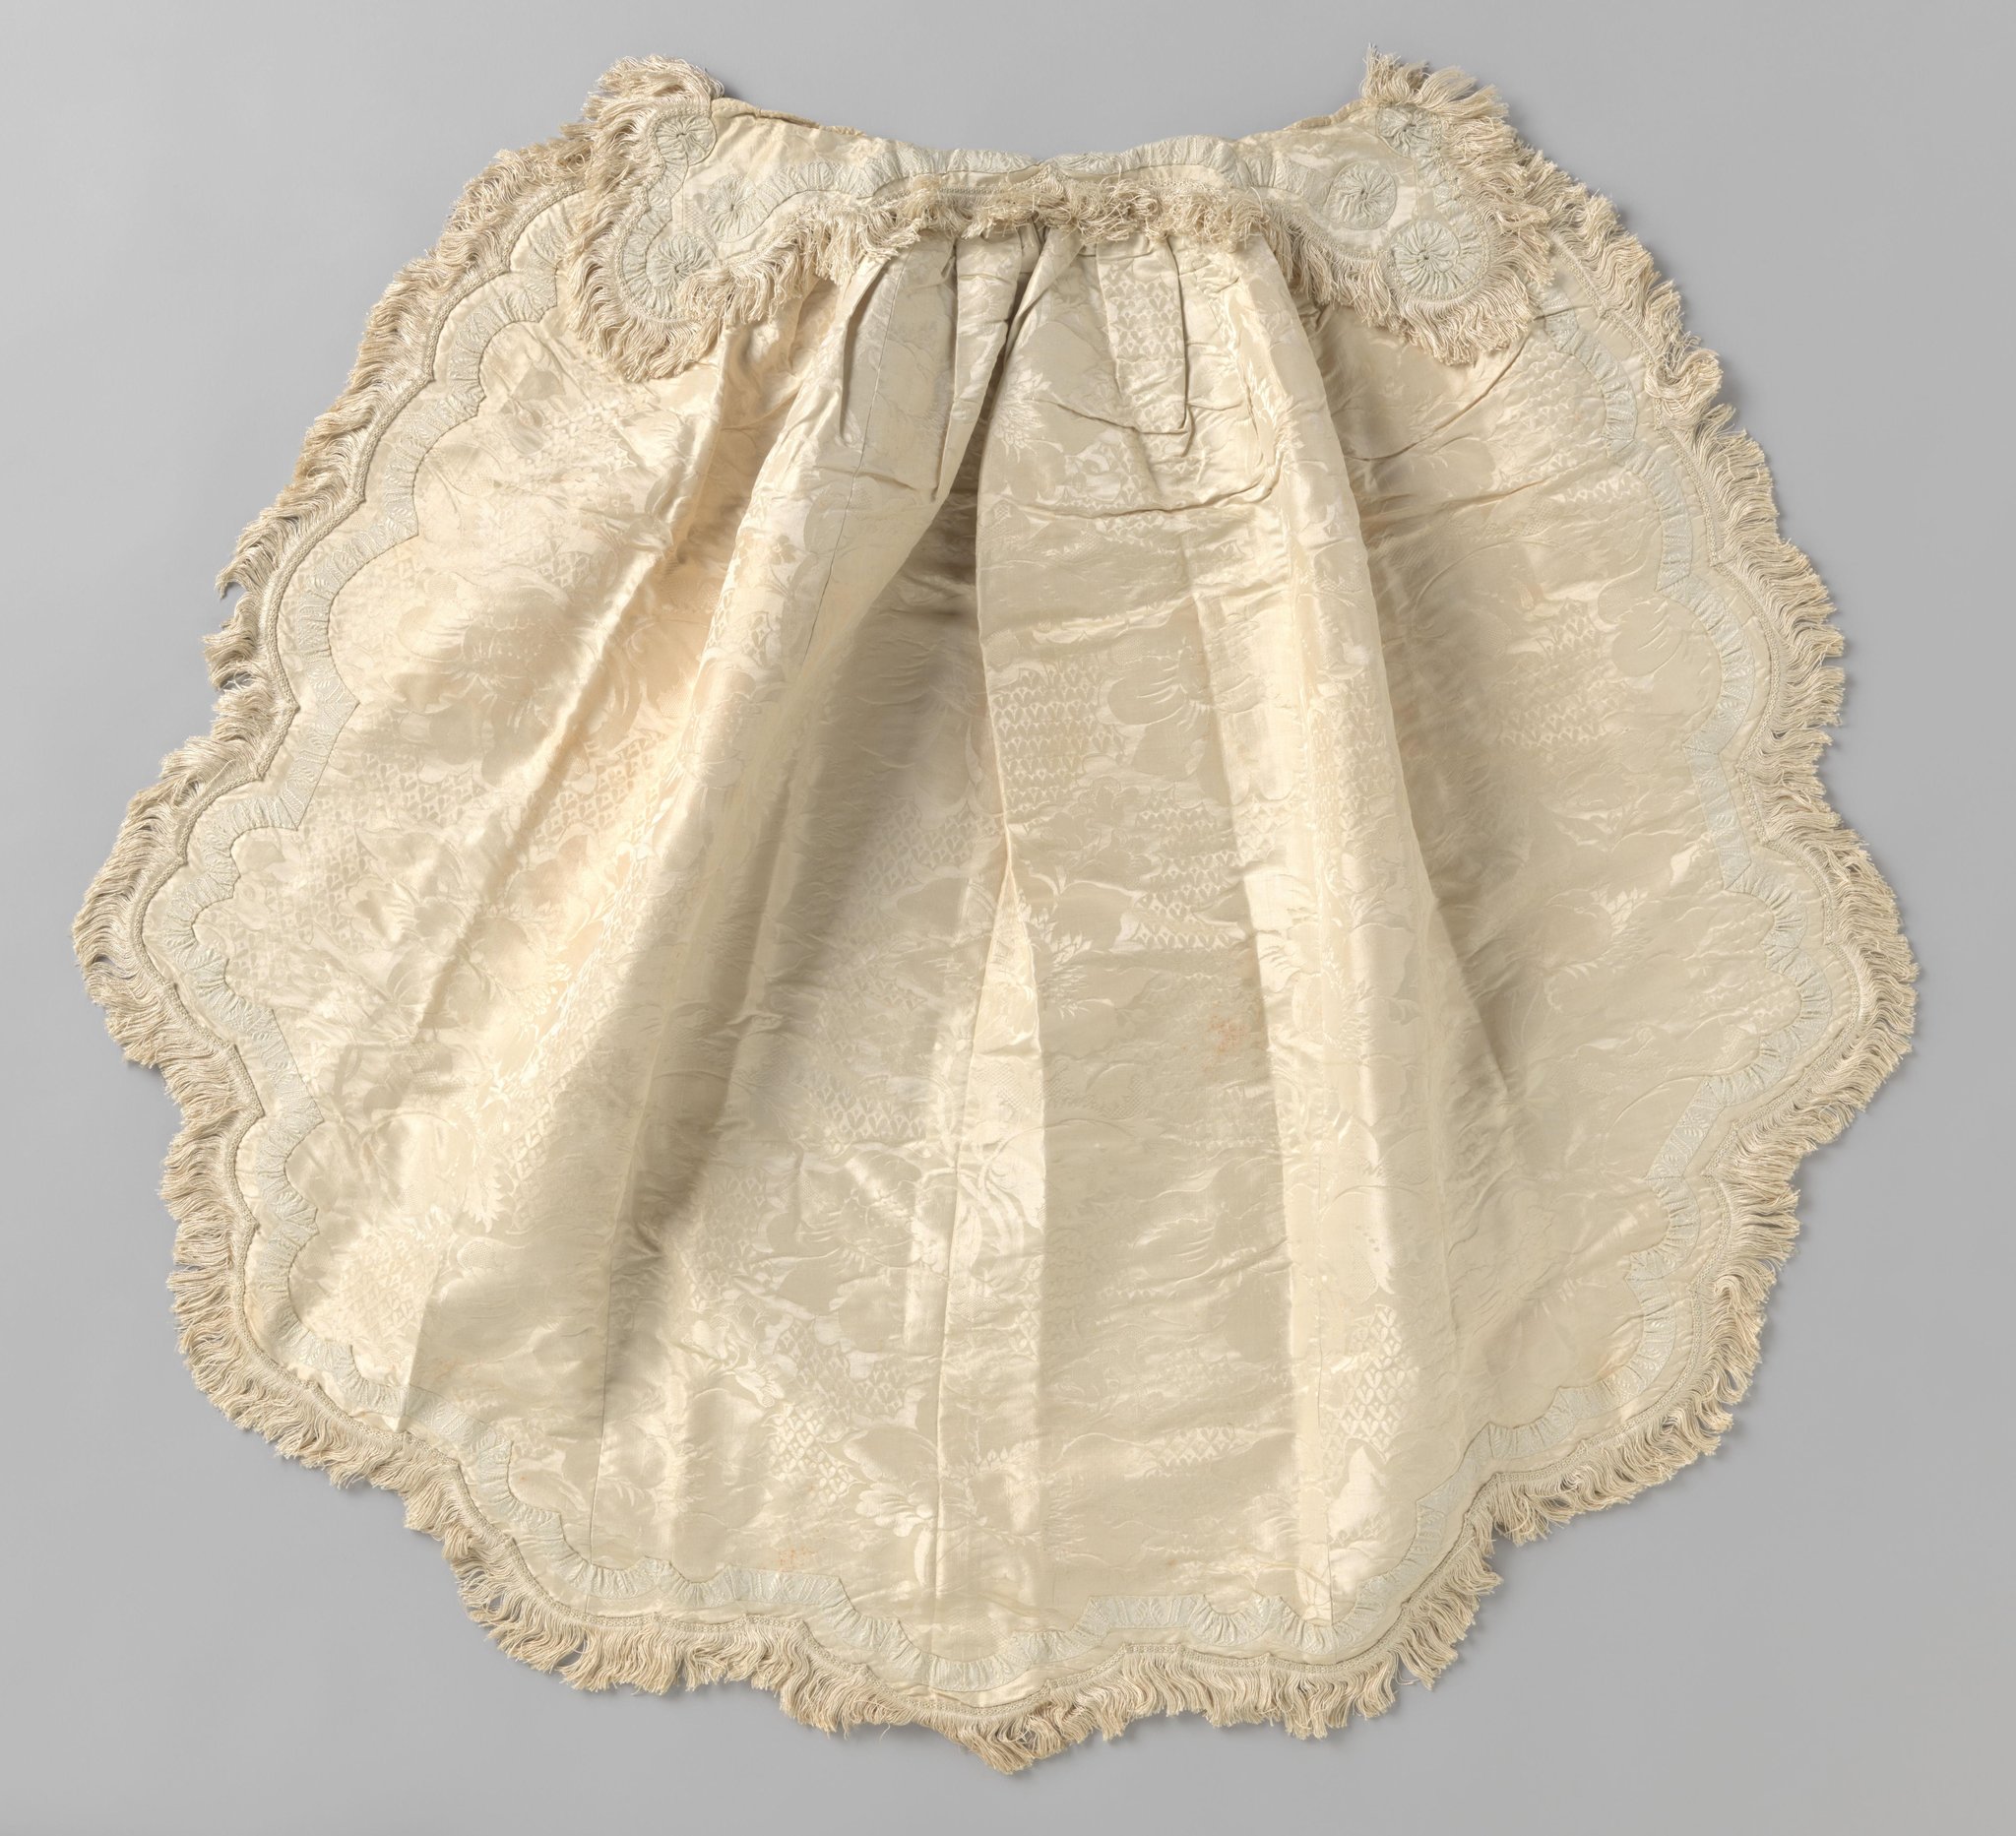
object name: zijdedamast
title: Wiegengordijn van wit zijdedamast met floraal patroon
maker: Anonymous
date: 1730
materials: silk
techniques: damask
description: Wiegengordijn van wit zijdedamast met floraal patroon en franjes langs de hele gelobte rand. Geplooid en gevoerd. Voorzien van metalen bevestigingshaken.